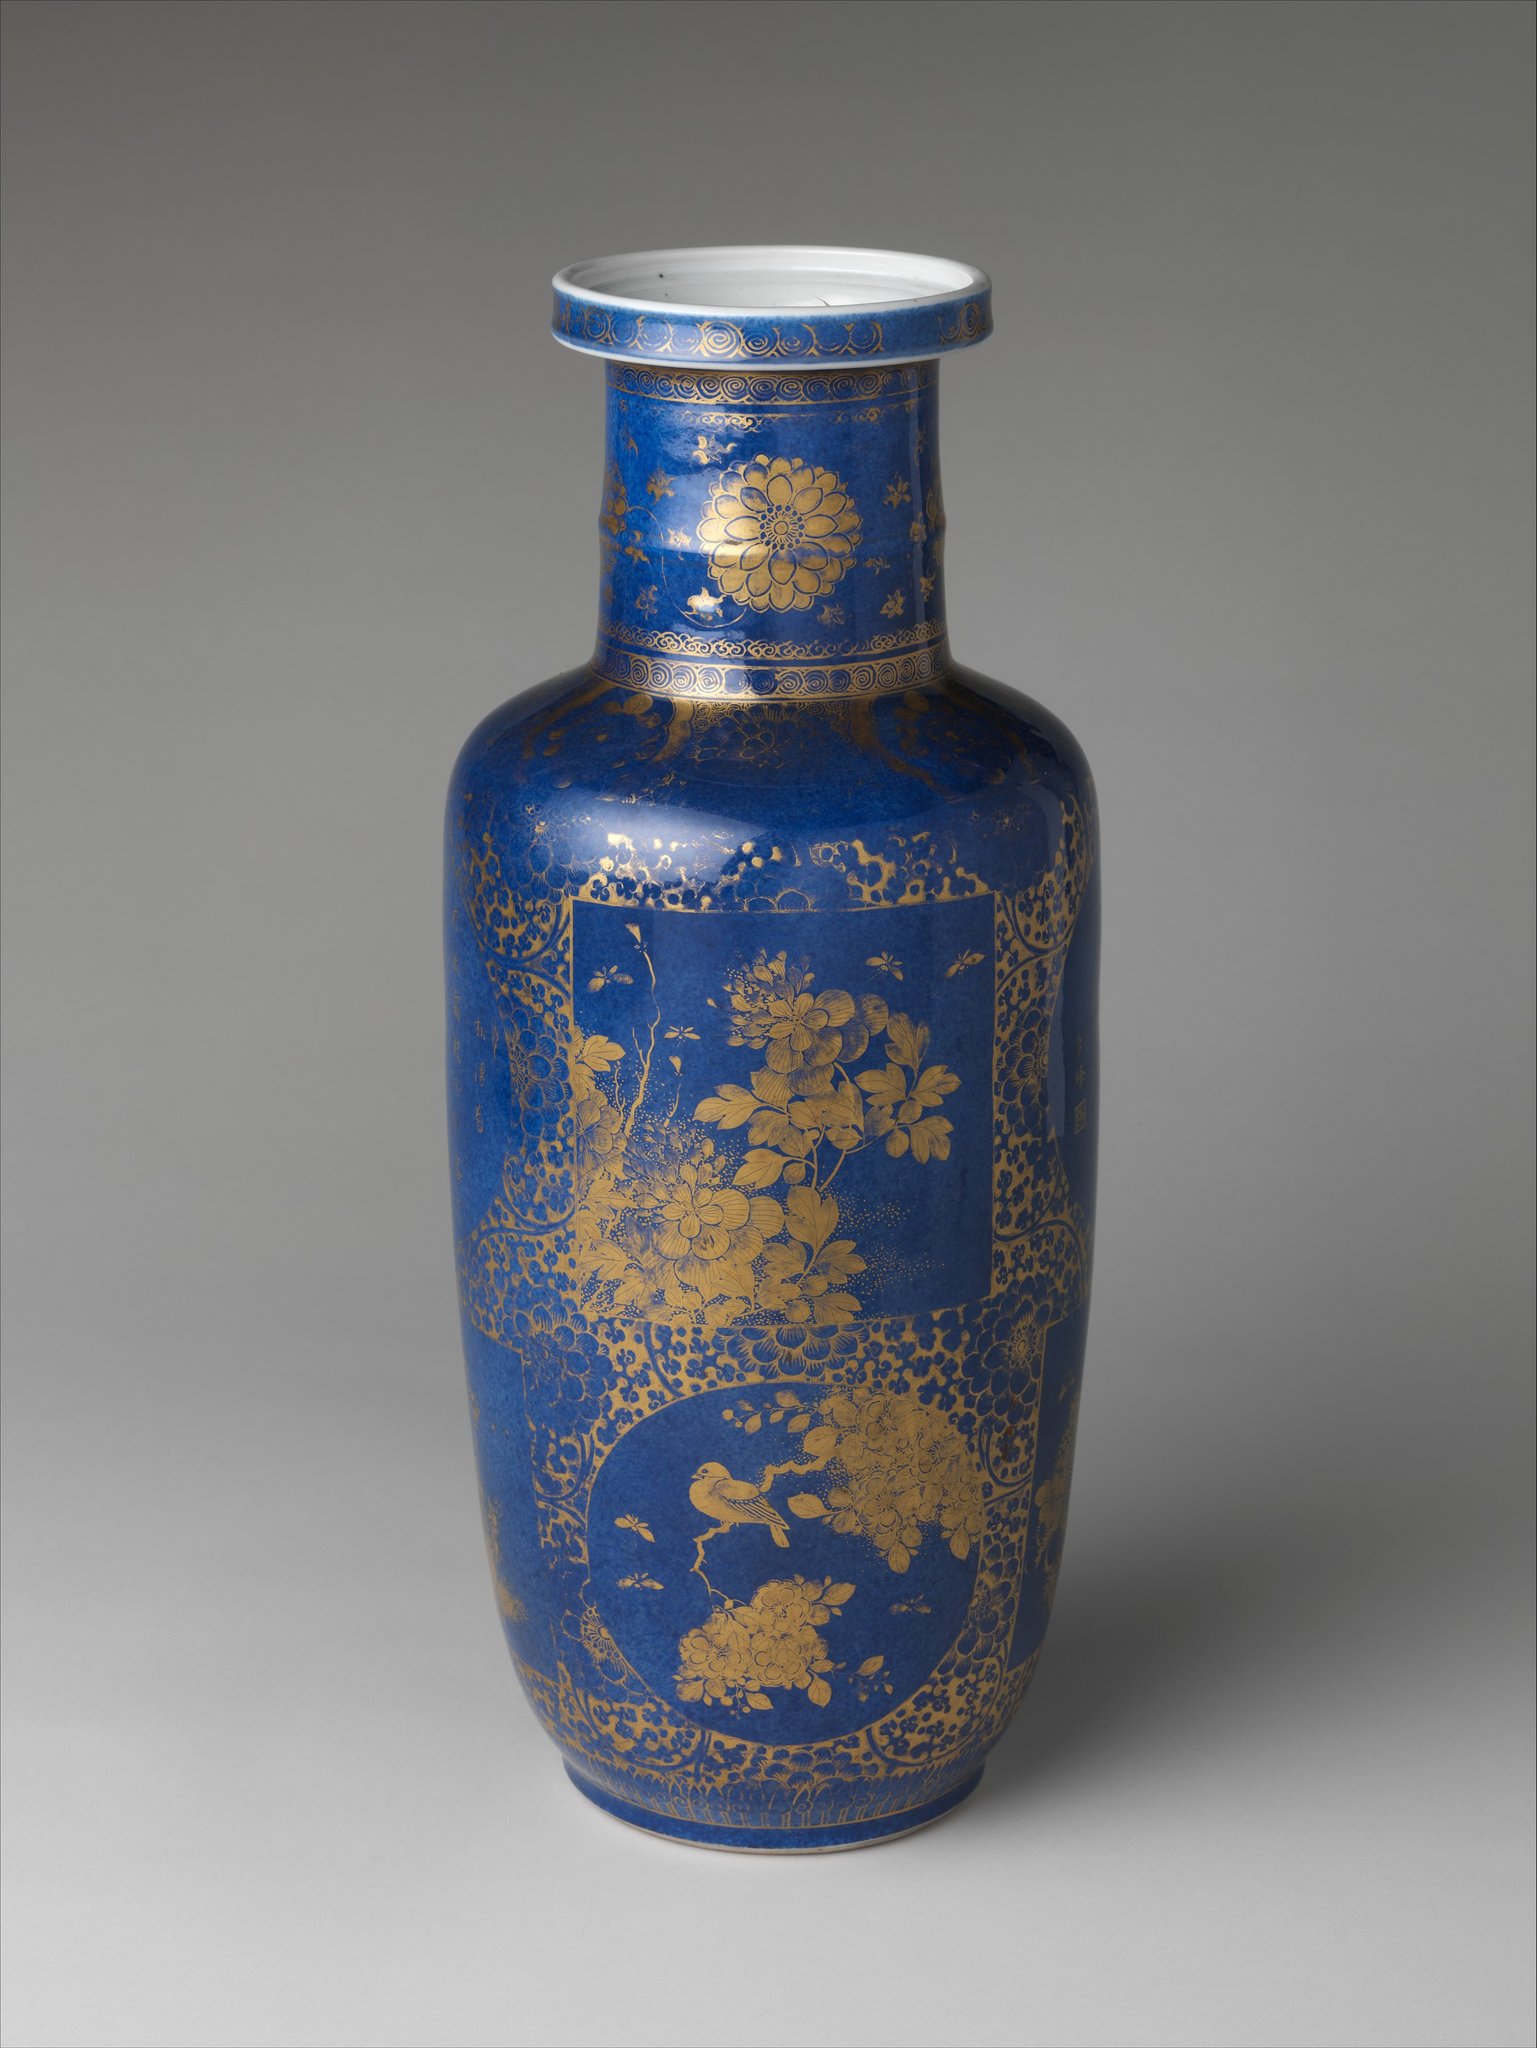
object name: vase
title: Vase decorated with flowers, birds, and poems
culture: chinese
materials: glaze, porcelain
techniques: gilding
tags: flowers